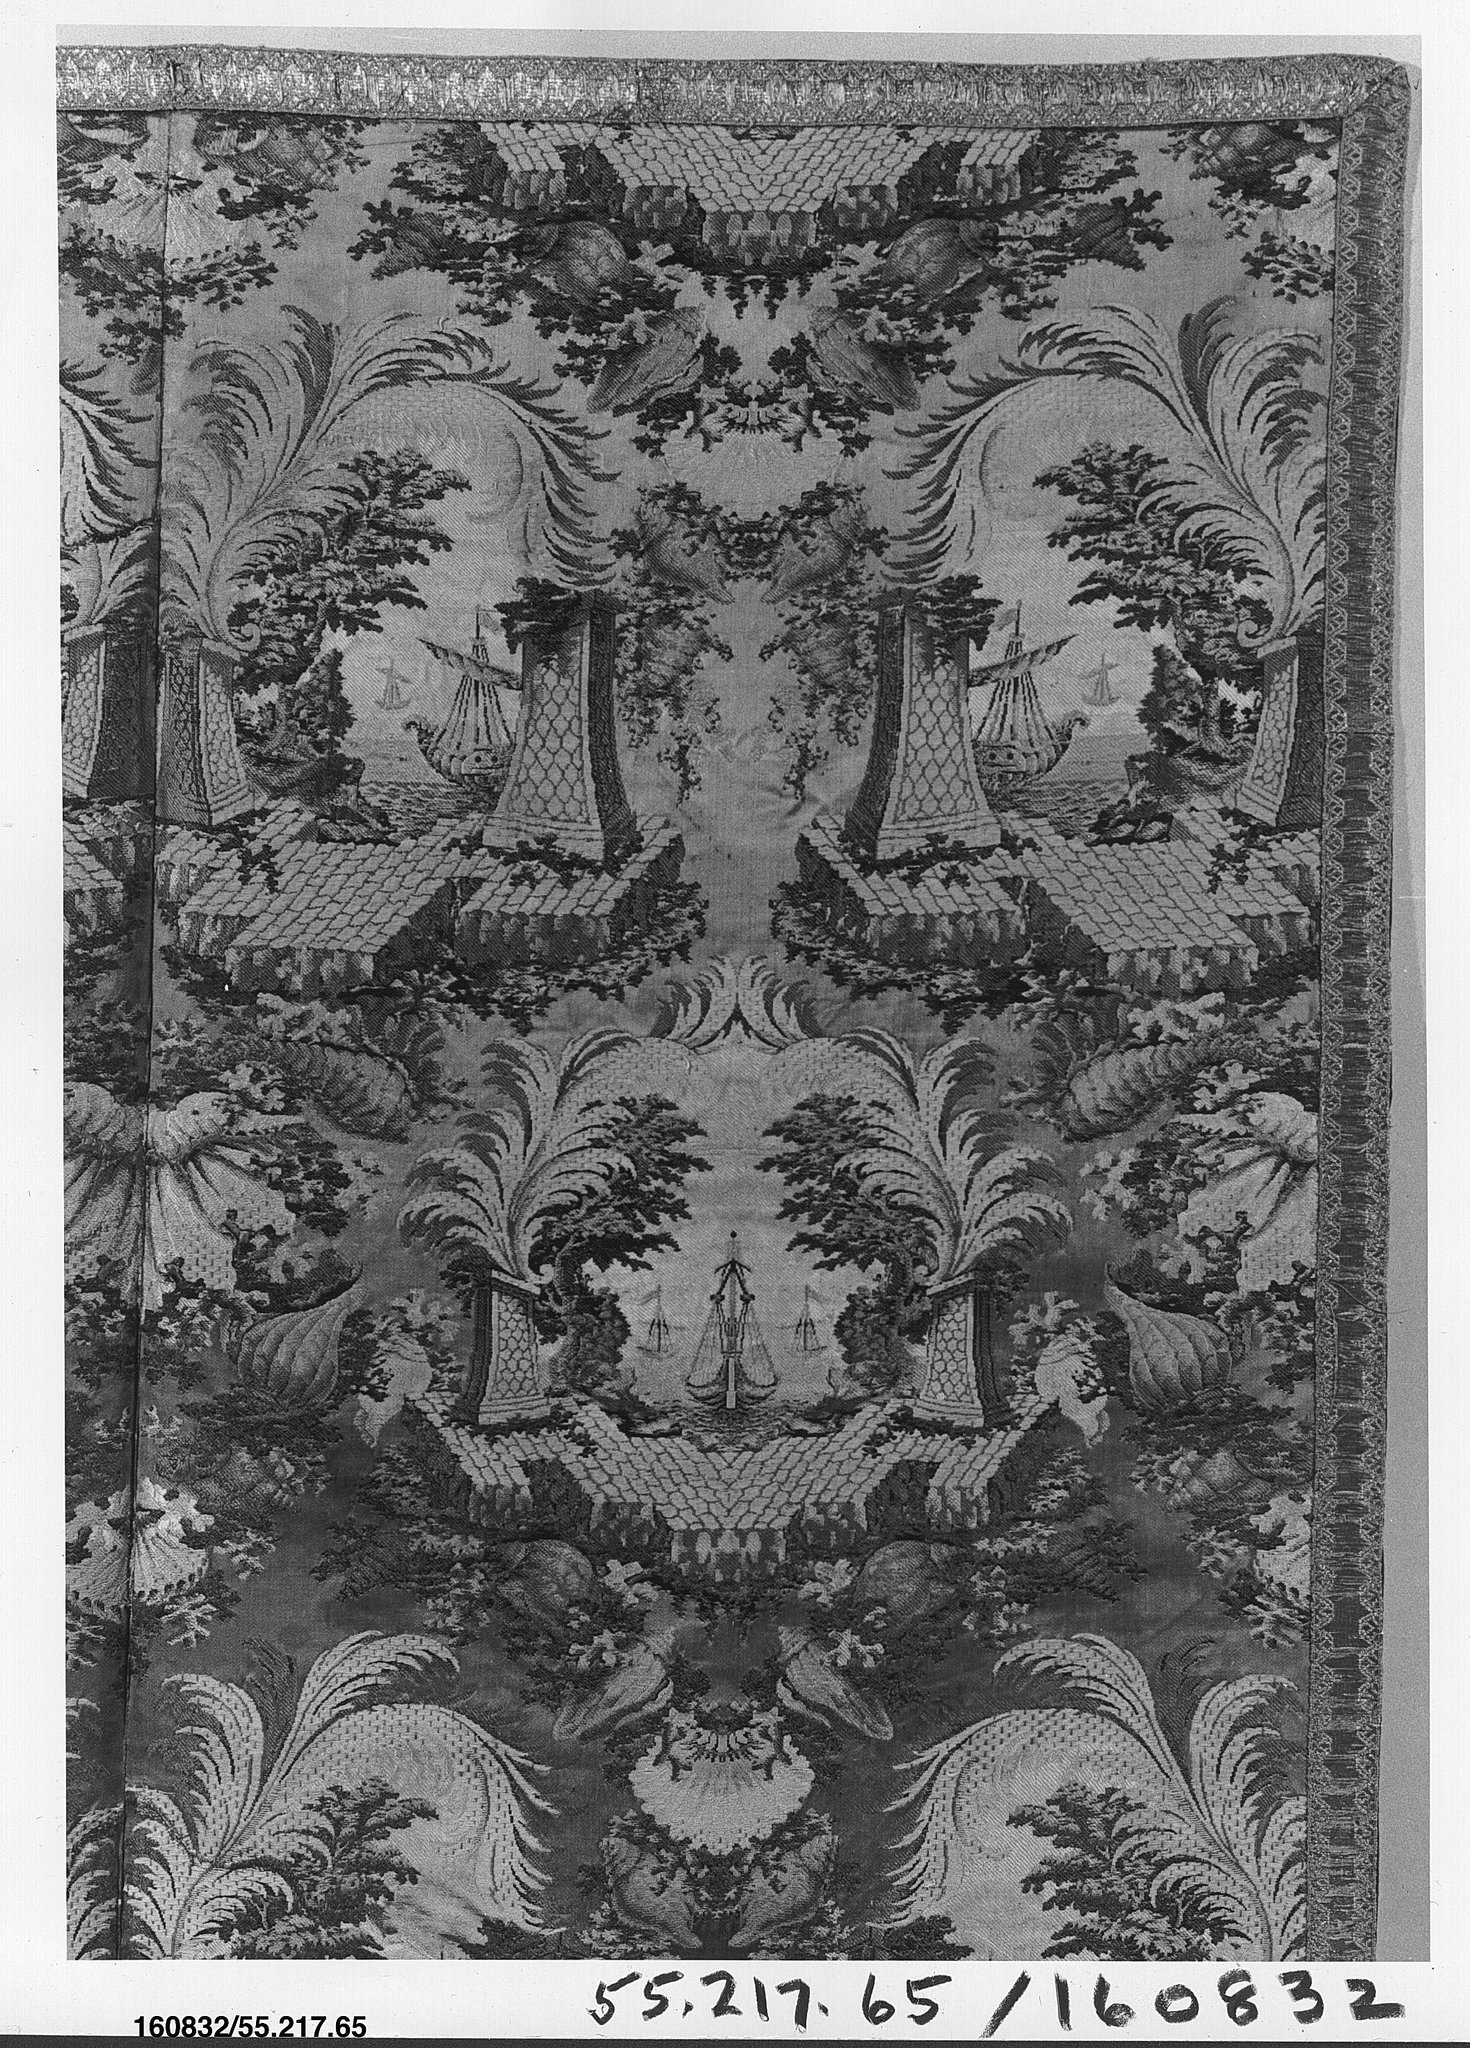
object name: piece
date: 1735-1740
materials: silk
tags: ships